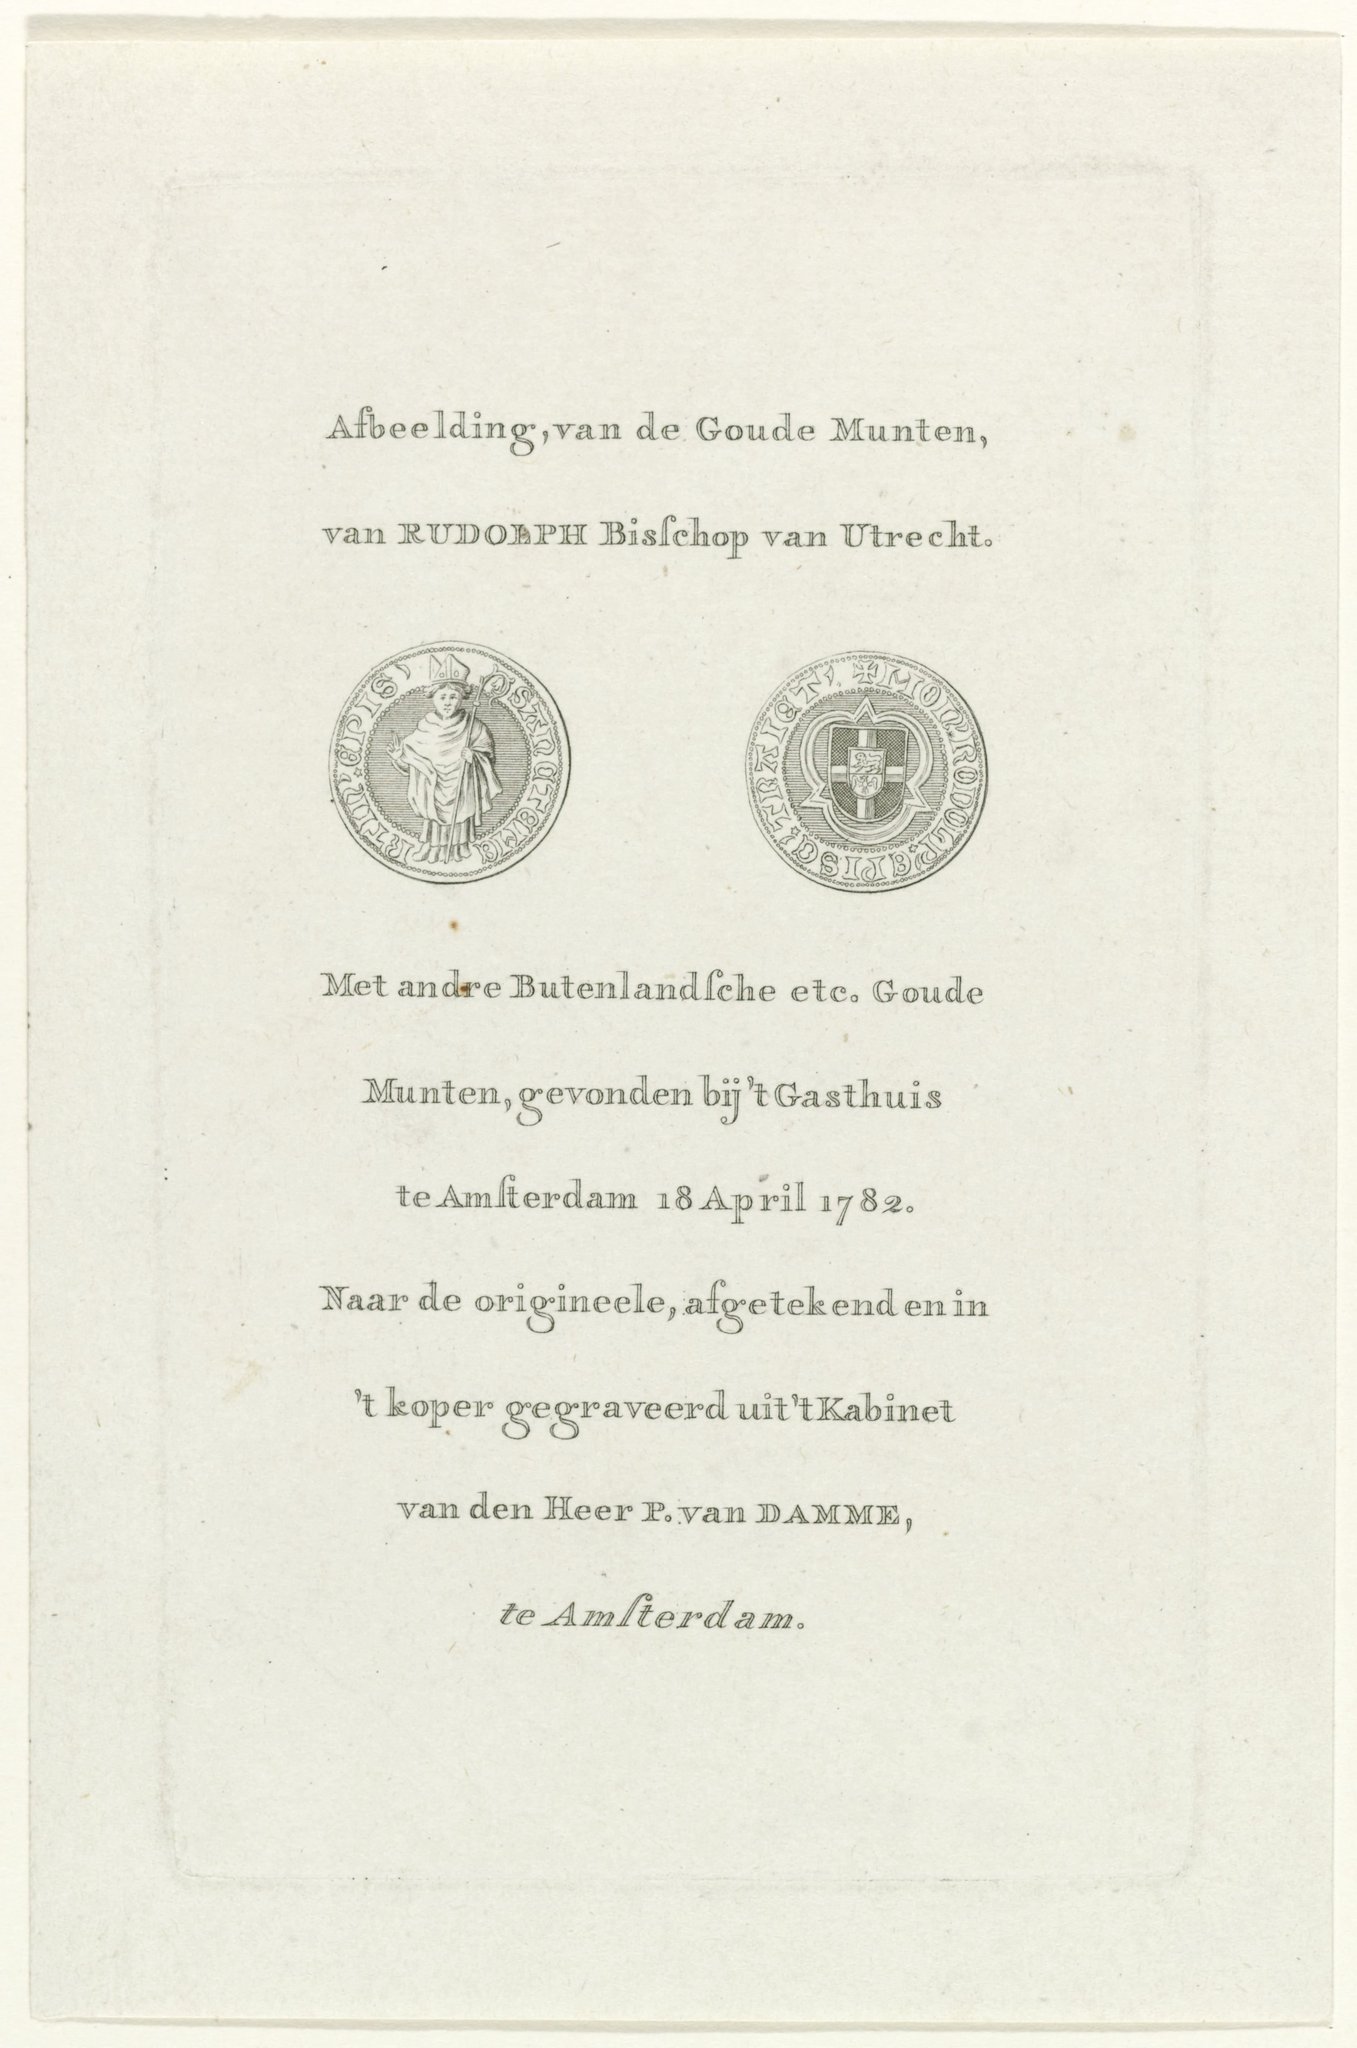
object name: print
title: Afbeelding, van de Goude Munten, van Rudolph Bisschop van Utrecht (...) gevonden bij 't Gasthuis te Amsterdam 18 April 1782 (...)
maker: Anonymous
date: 1782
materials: paper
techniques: etching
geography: northern netherlands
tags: coin, amsterdam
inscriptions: collector's mark: Lugt 2228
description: Gouden munten van Rudolf van Diepholt, bisschop van Utrecht van 1423 tot 1455, en andere munten gevonden bij het Gasthuis in Amsterdam op 18 april 1782.